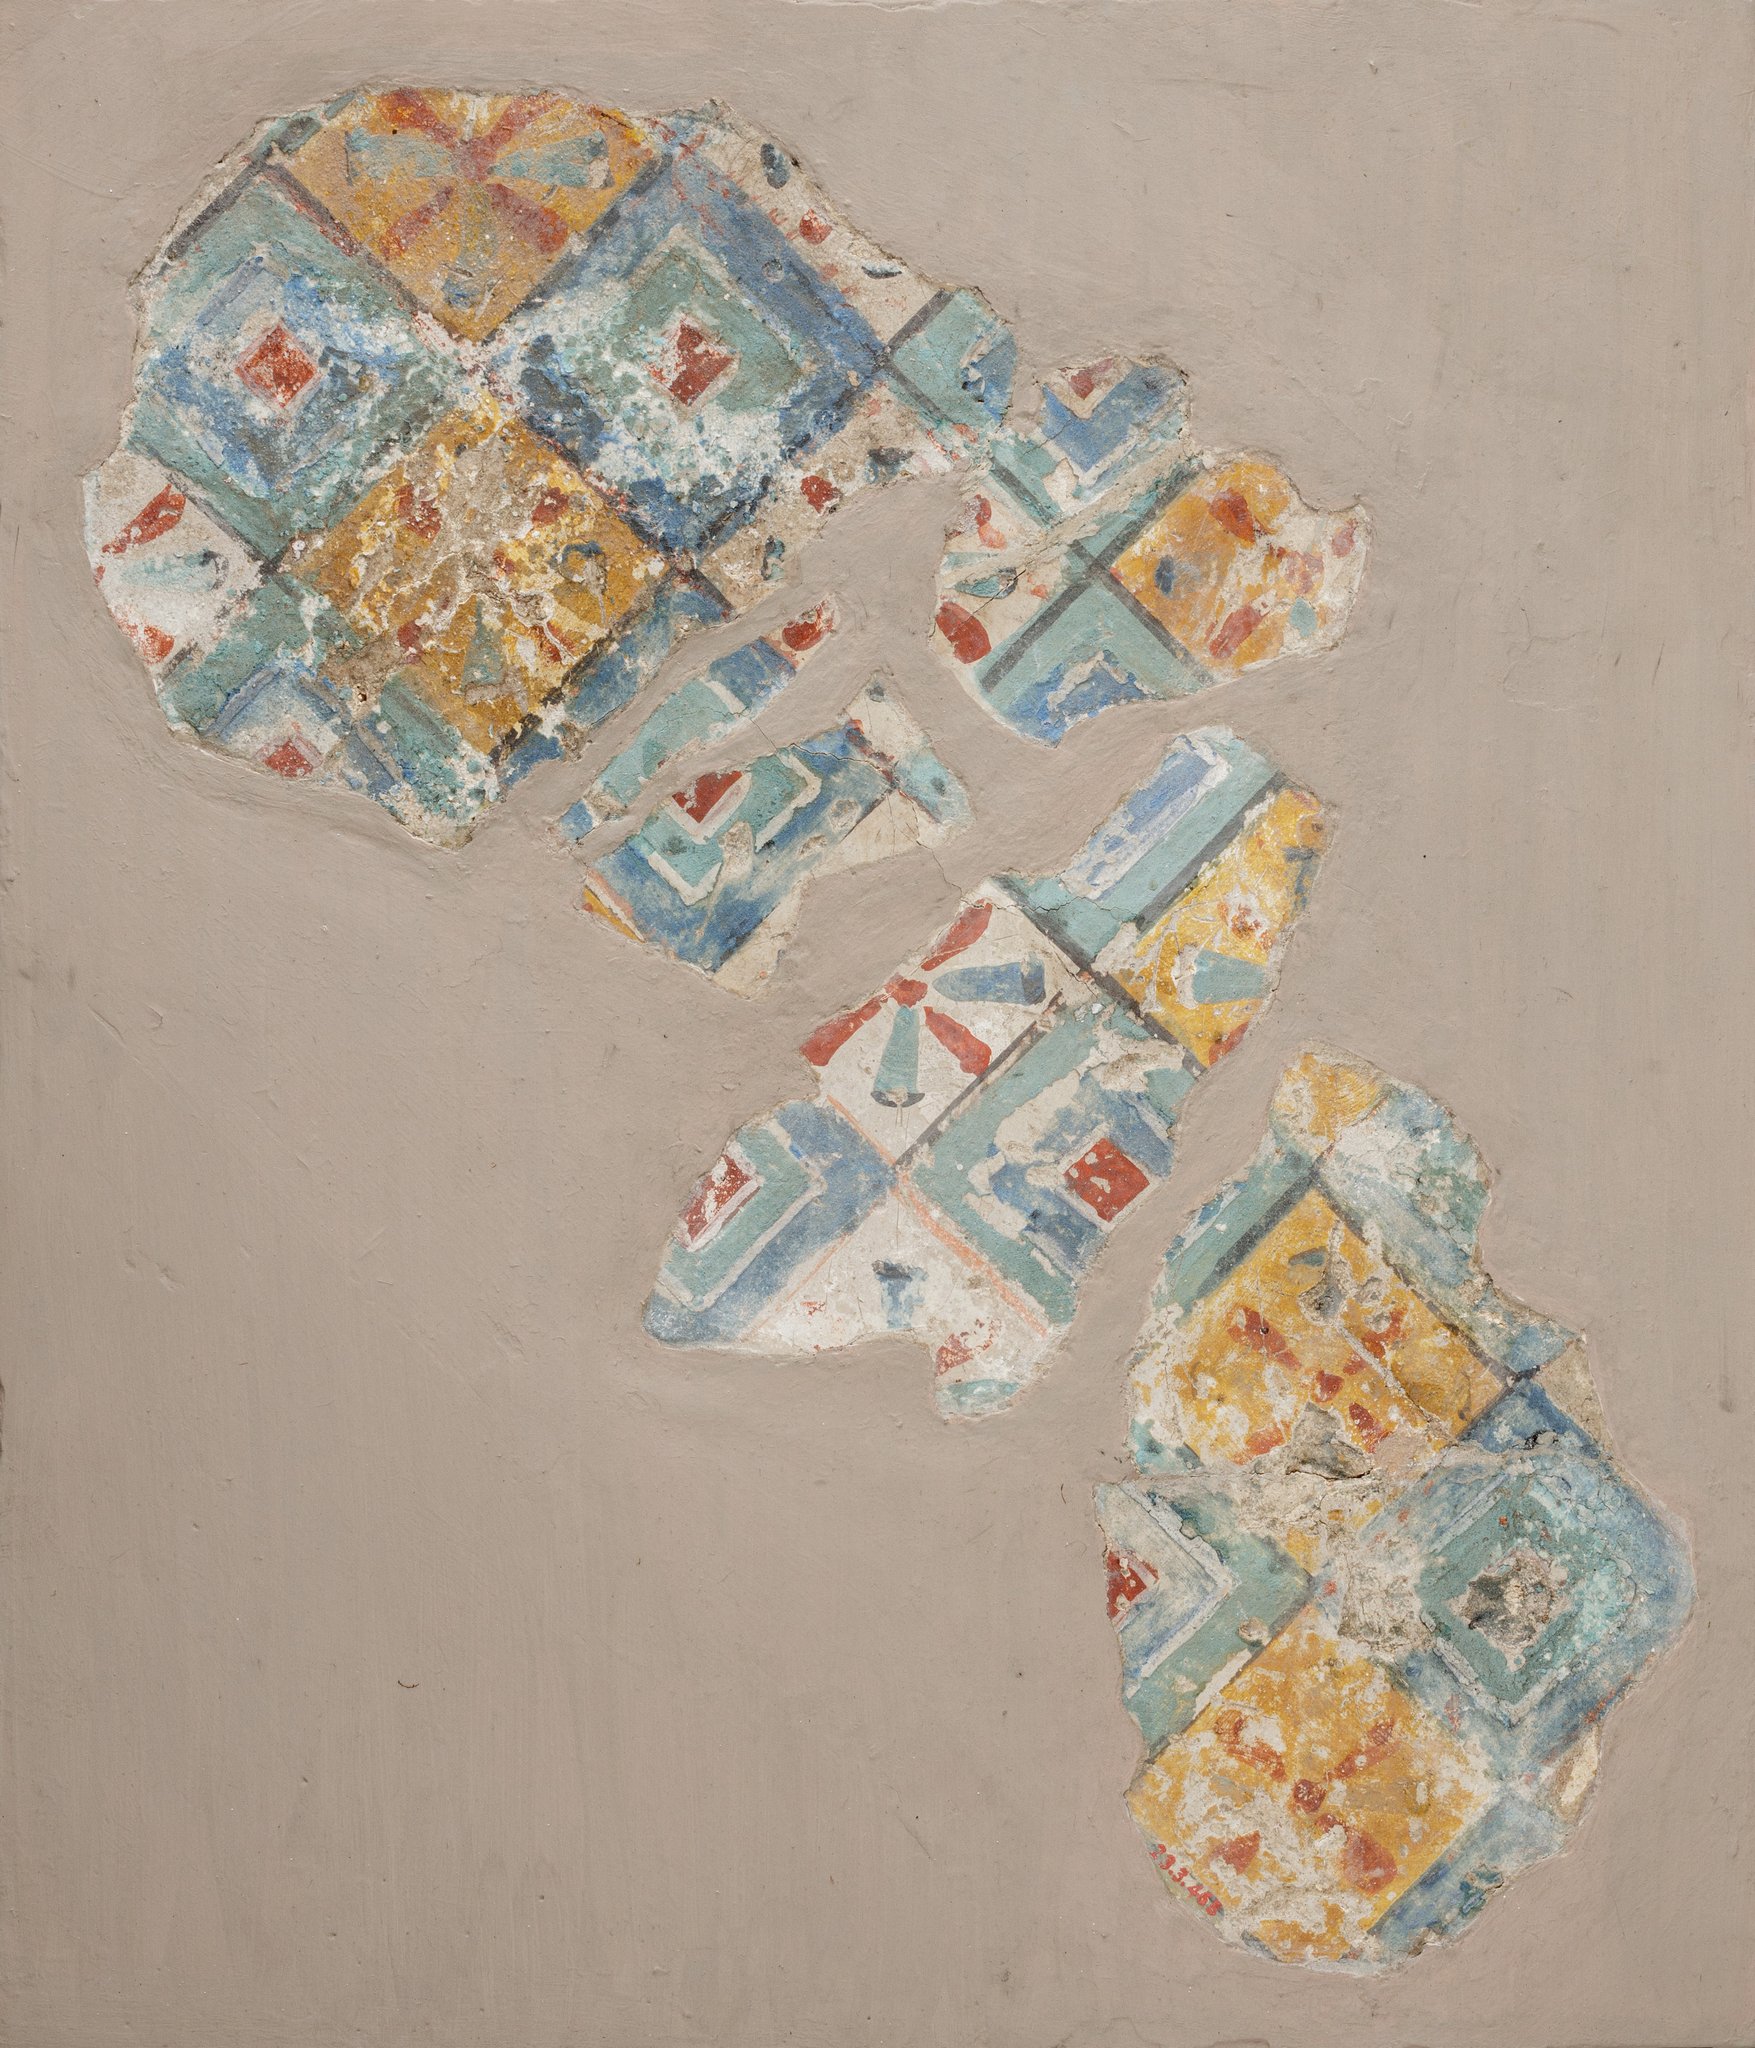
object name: ceiling painting, senenmut, tt 71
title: Ceiling Painting from the Tomb Chapel of Senenmut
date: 1479-1458 BCE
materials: mud, paint, plaster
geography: egypt